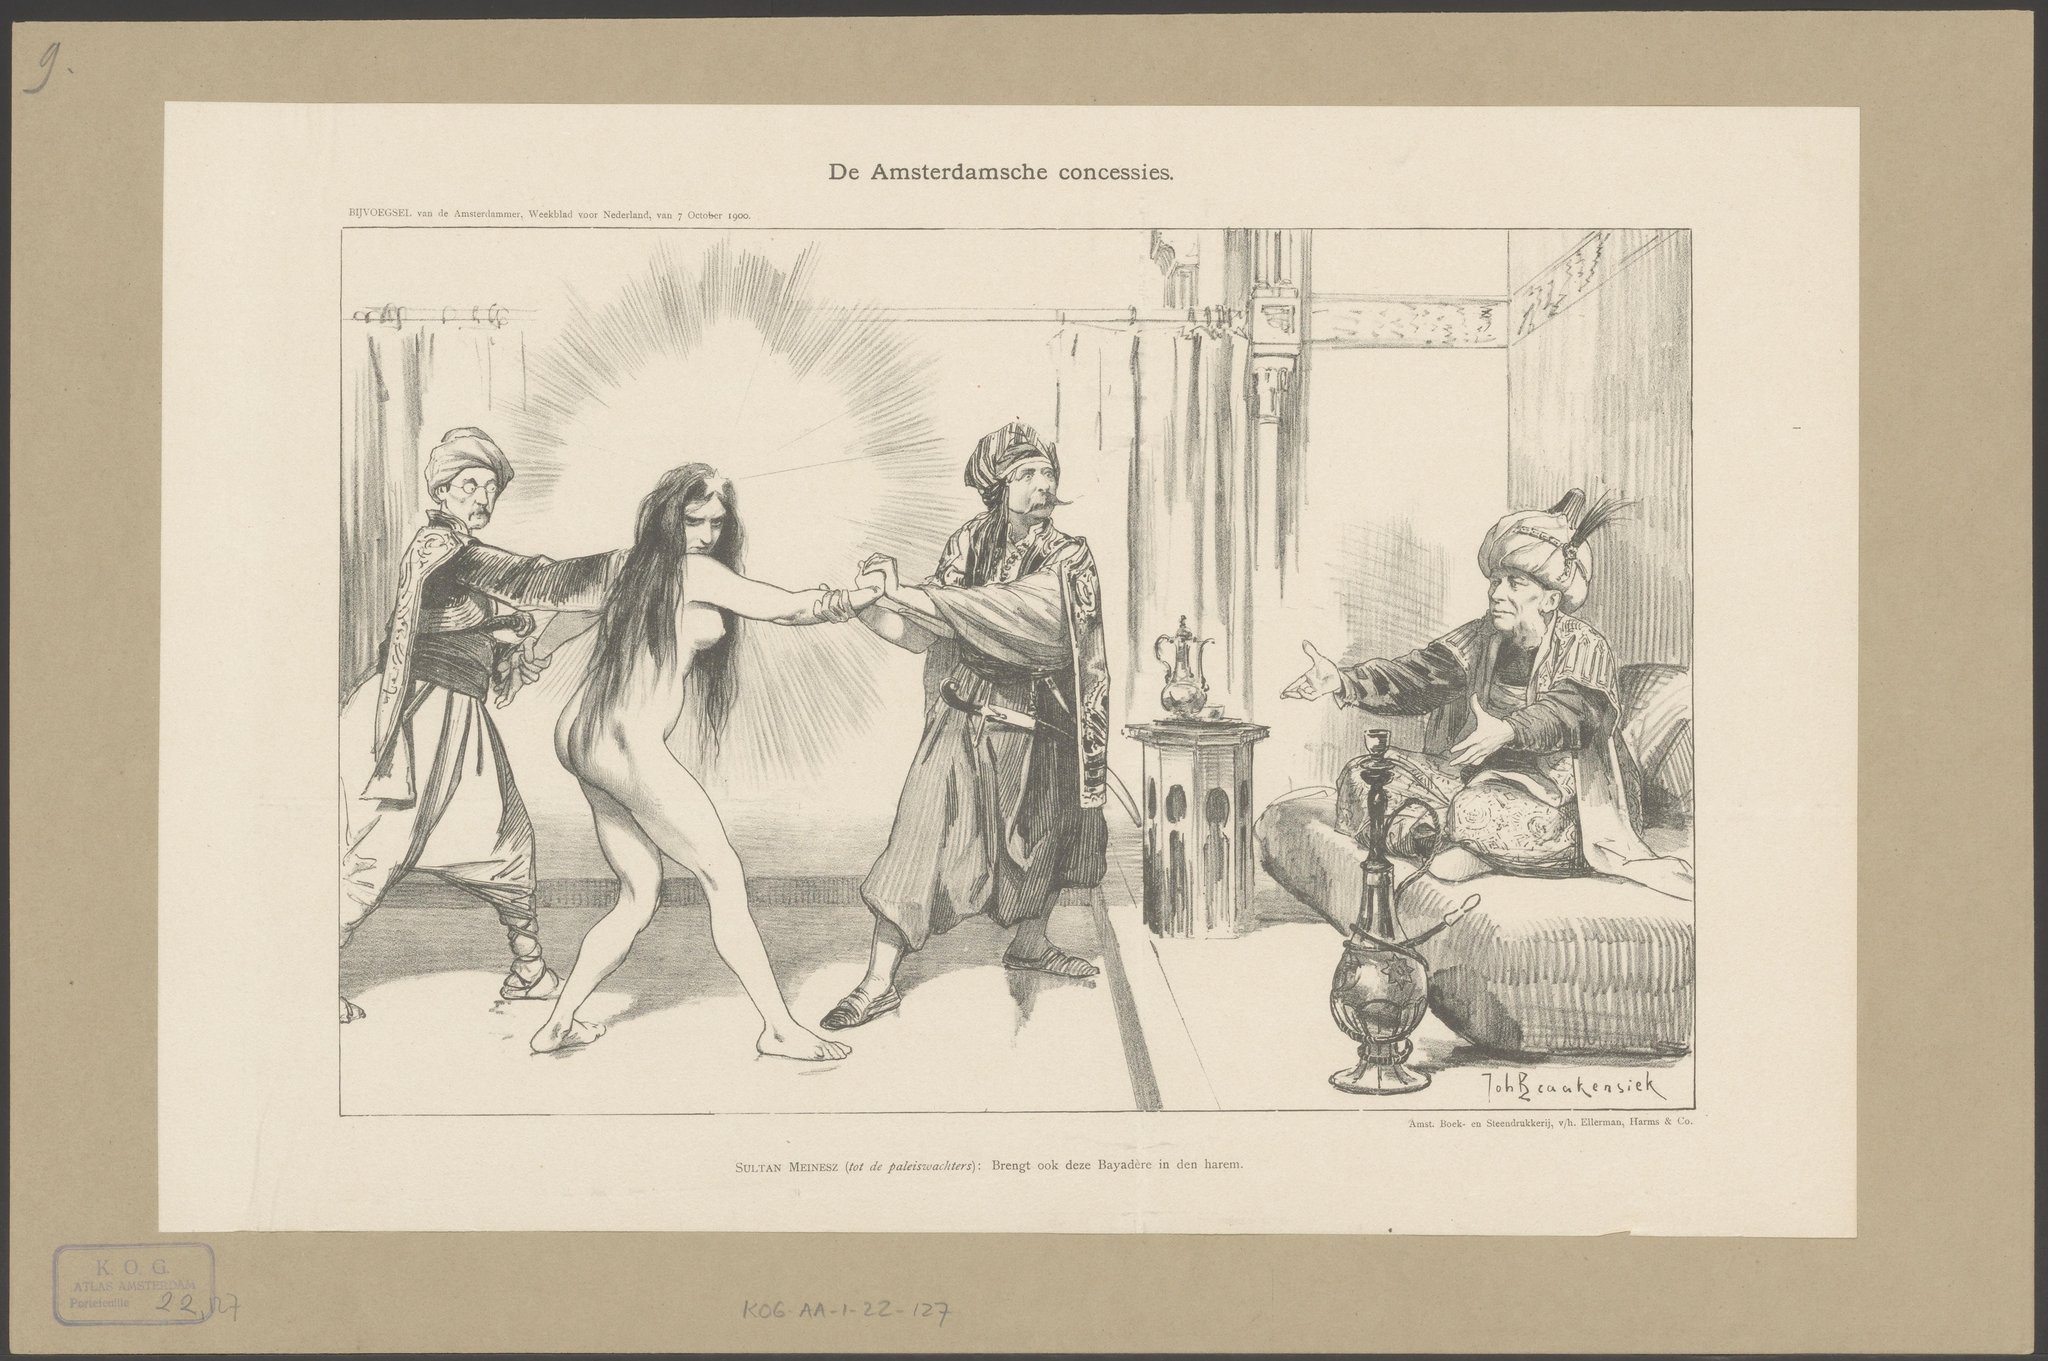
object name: cartoon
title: De Amsterdamsche concessies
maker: johan braakensiek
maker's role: draughtsman, print maker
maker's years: 1858-1940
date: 1900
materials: paper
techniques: letterpress printing, lithograph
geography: amsterdam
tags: harlingen, politician, water-pipe, hookah, narghile, woman (showing herself) undressed, quasi-nude, head-gear: turban, harem, political caricatures and satires, amsterdam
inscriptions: collector's mark: Lugt 1641b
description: Gepubliceerd als bijvoegsel van 'De Amsterdammer', 7 oktober 1900.